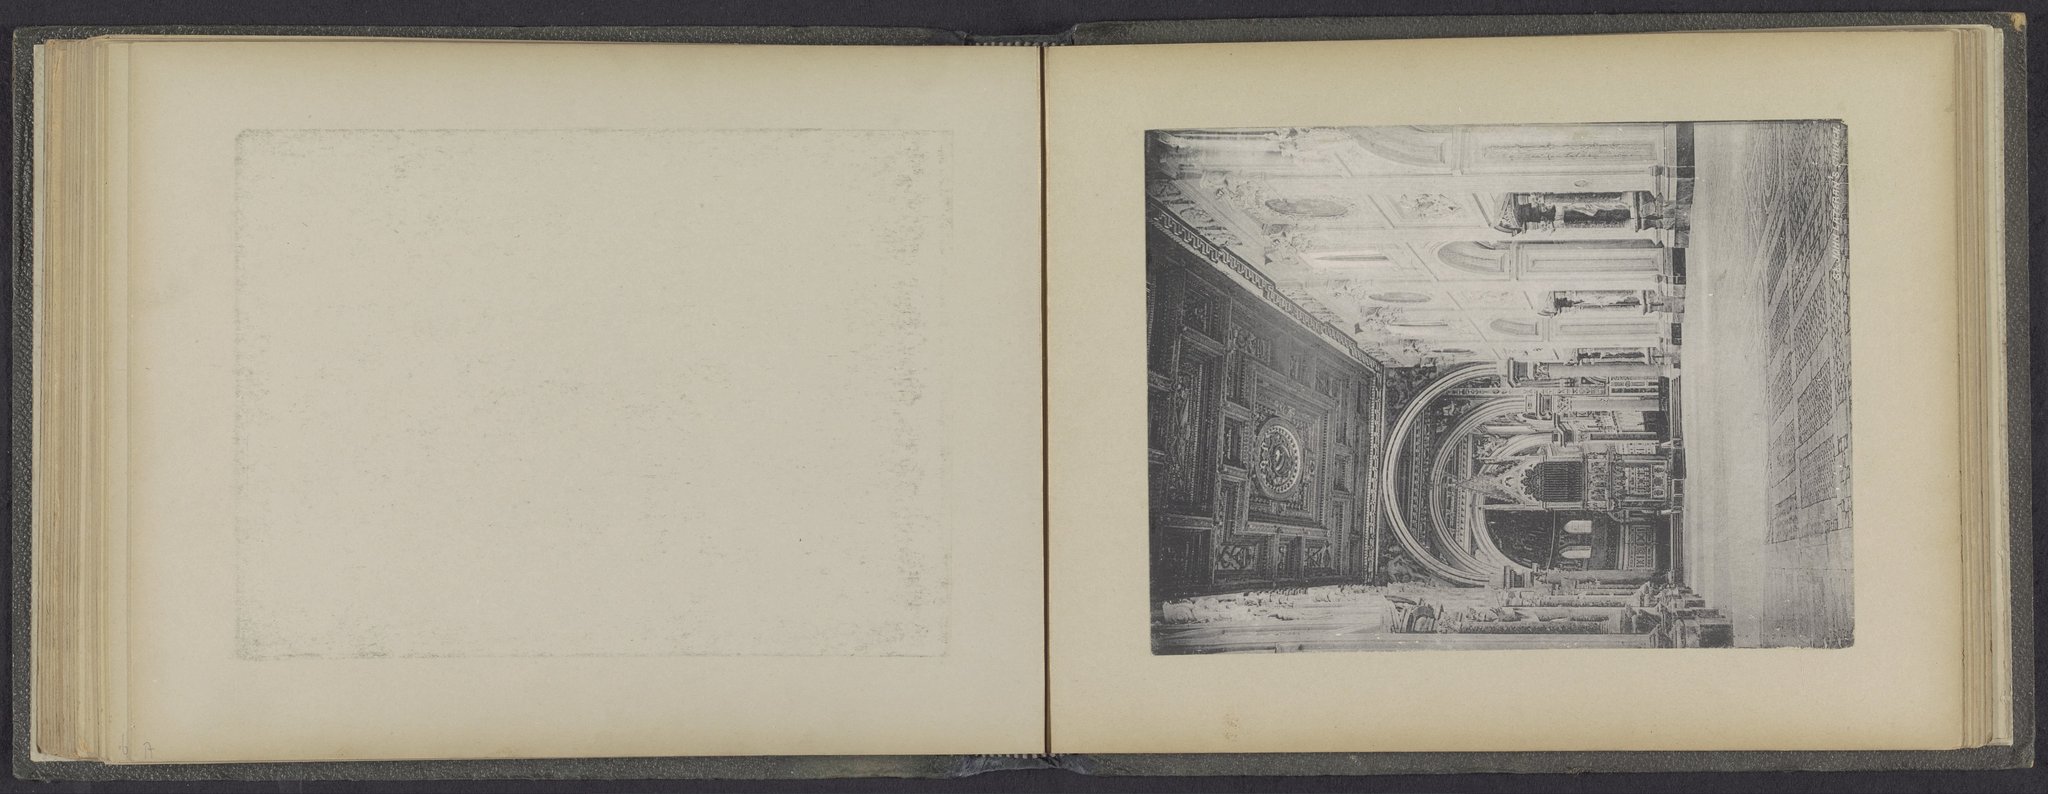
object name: page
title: St. John Lateran's church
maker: samuel j. beckett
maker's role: fotograaf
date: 1890-1900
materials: paper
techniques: photograph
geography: sint-jan van lateranen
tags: parts of church interior: aisle, interior of church